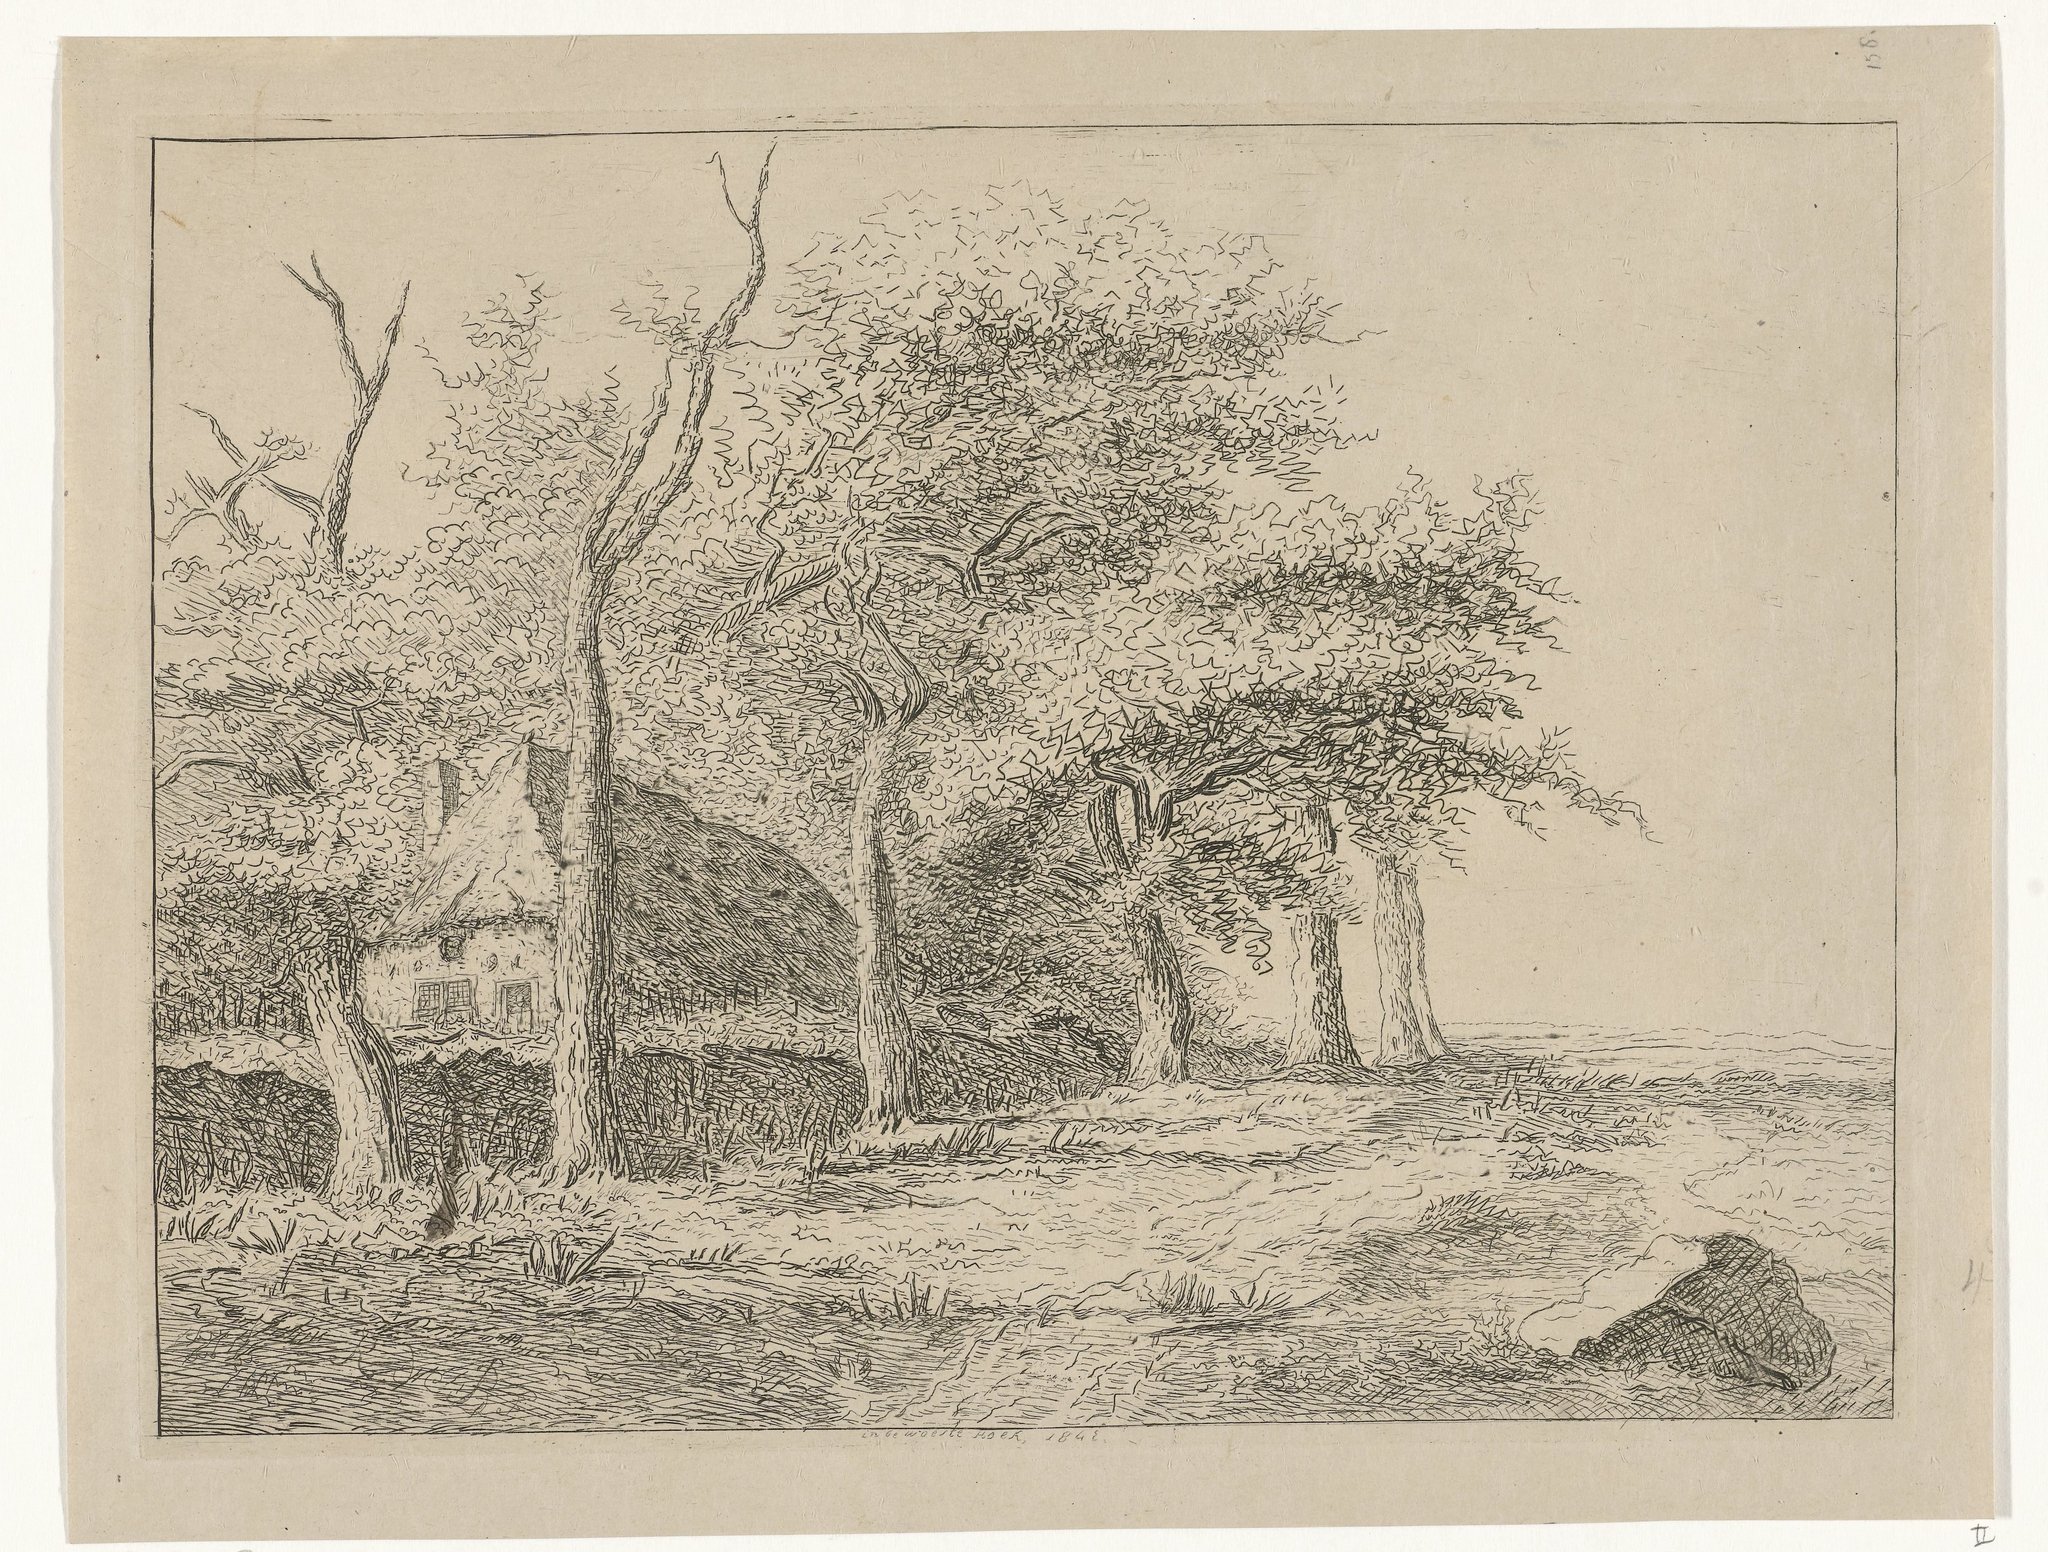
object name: print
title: Rij bomen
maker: reinierus albertus ludovicus baron van isendoorn à blois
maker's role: print maker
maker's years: 1786-1856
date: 1796-1856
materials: paper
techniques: engraving, etching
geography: vaassen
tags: trees, farm or solitary house in landscape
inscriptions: collector's mark: Lugt 2228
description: Een rij bomen langs een wal. Achter de wal een woning.